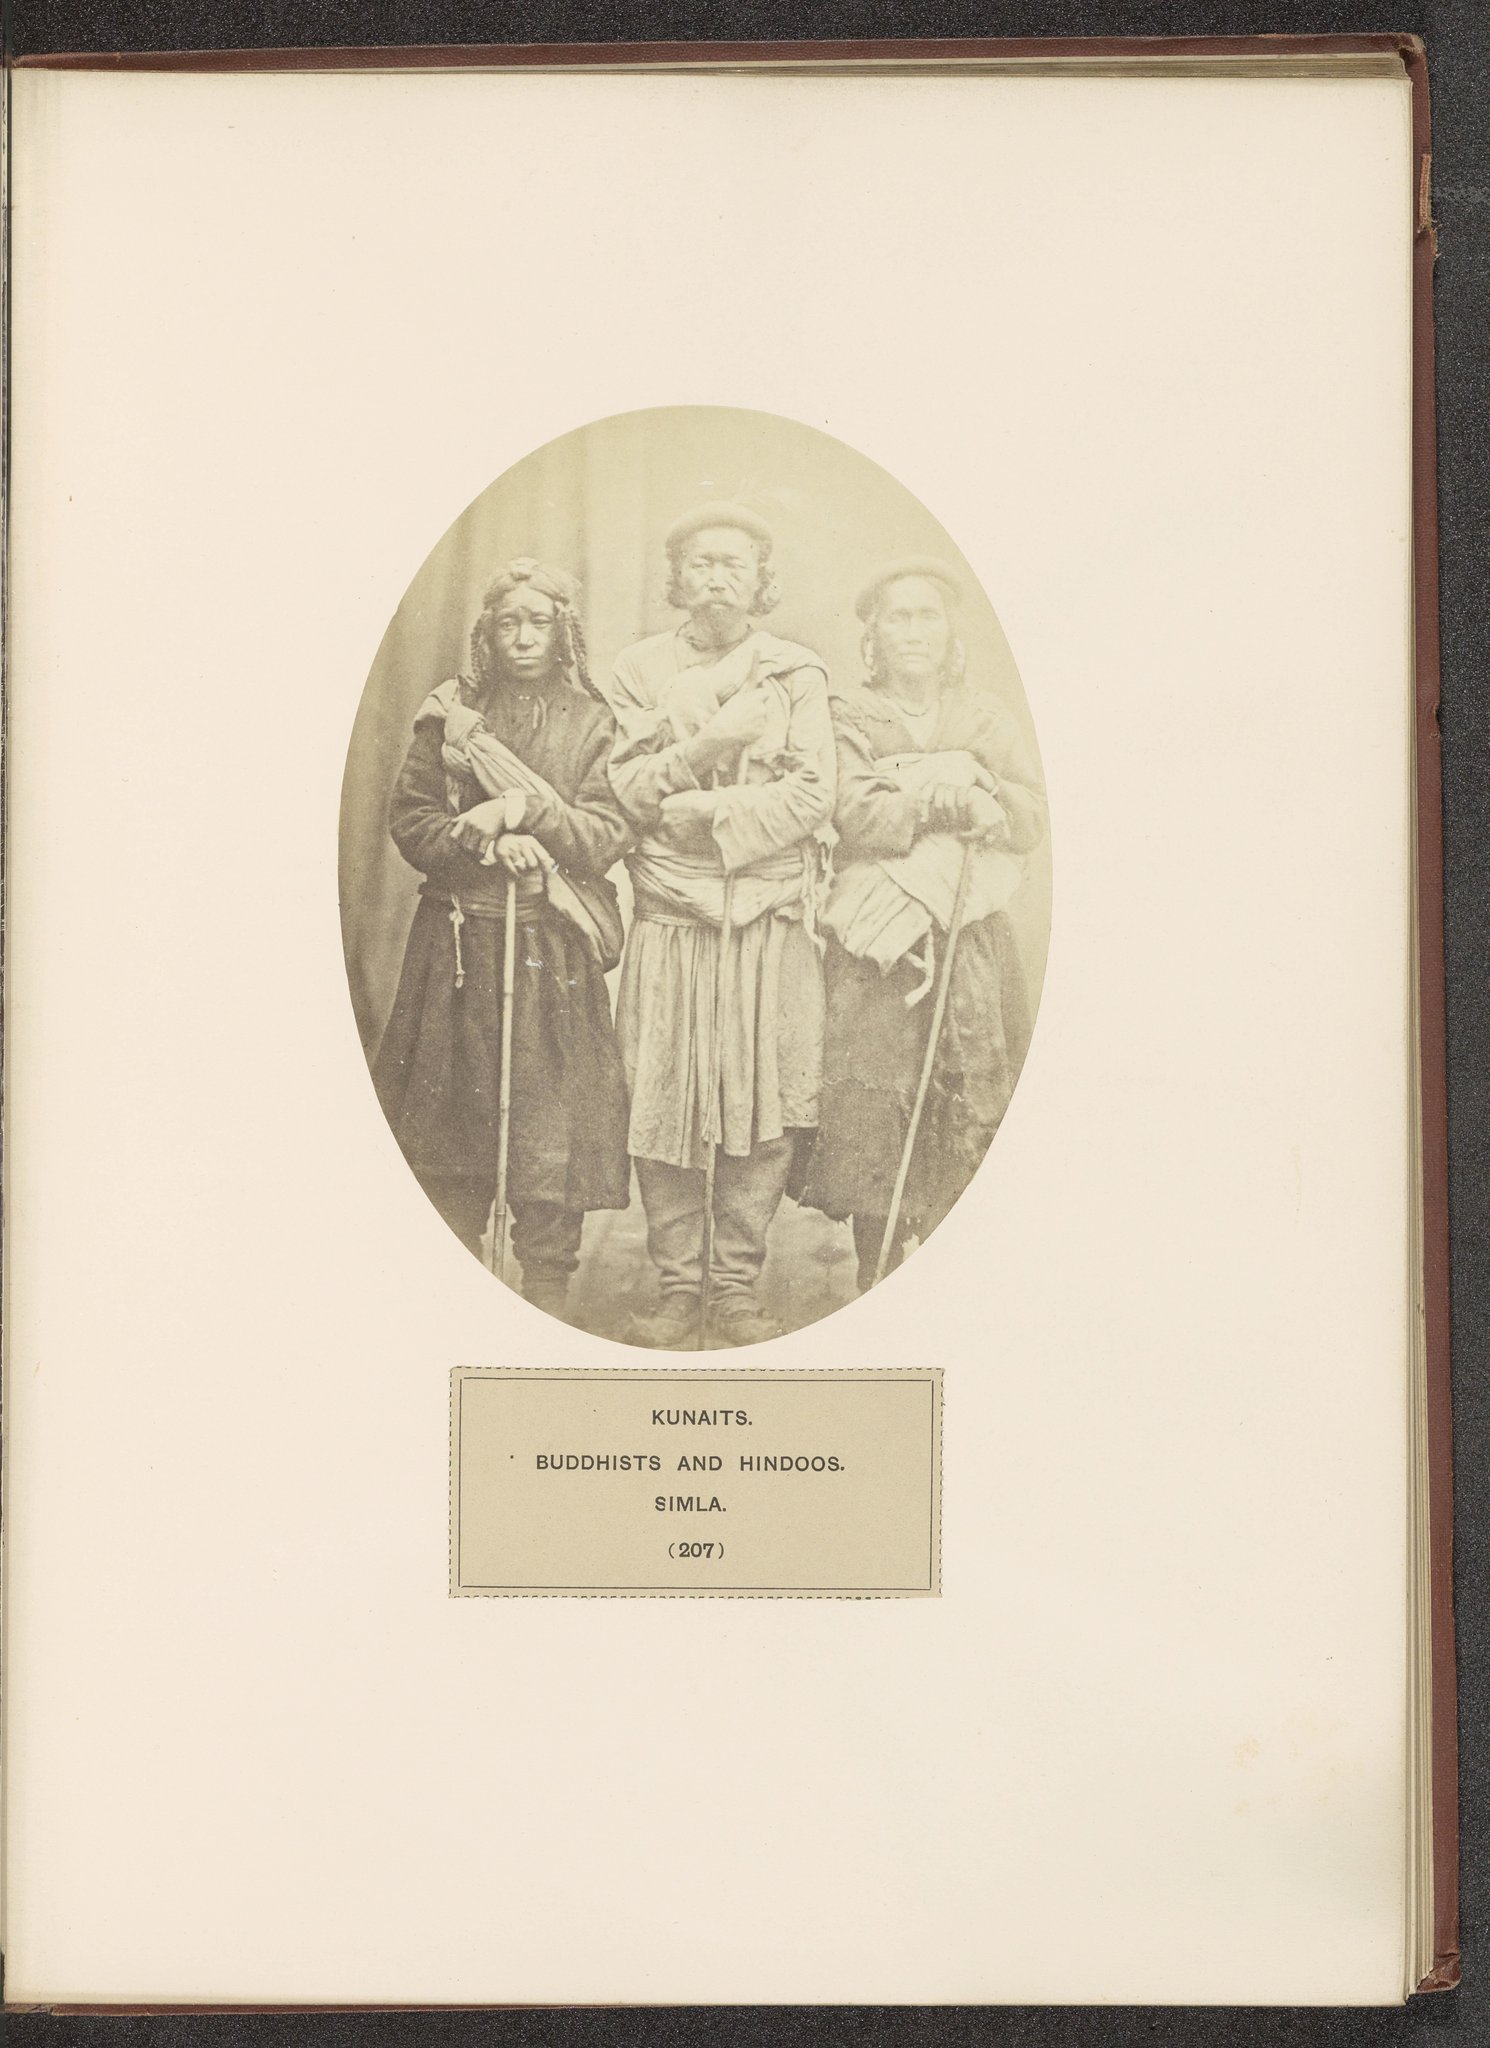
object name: photograph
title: Portrait of three men from the Kanet community of Shimla, Himachal Pradesh, India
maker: Anonymous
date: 1859-1869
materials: photographic support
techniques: albumen print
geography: shimla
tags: human races; peoples; nationalities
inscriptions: inscription: ‘KUNAITS./ BUDDHISTS AND HINDOOS./ SIMLA.’, number: ‘(207)’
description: De Kanet-gemeenschap is ook bekend als Kunait.